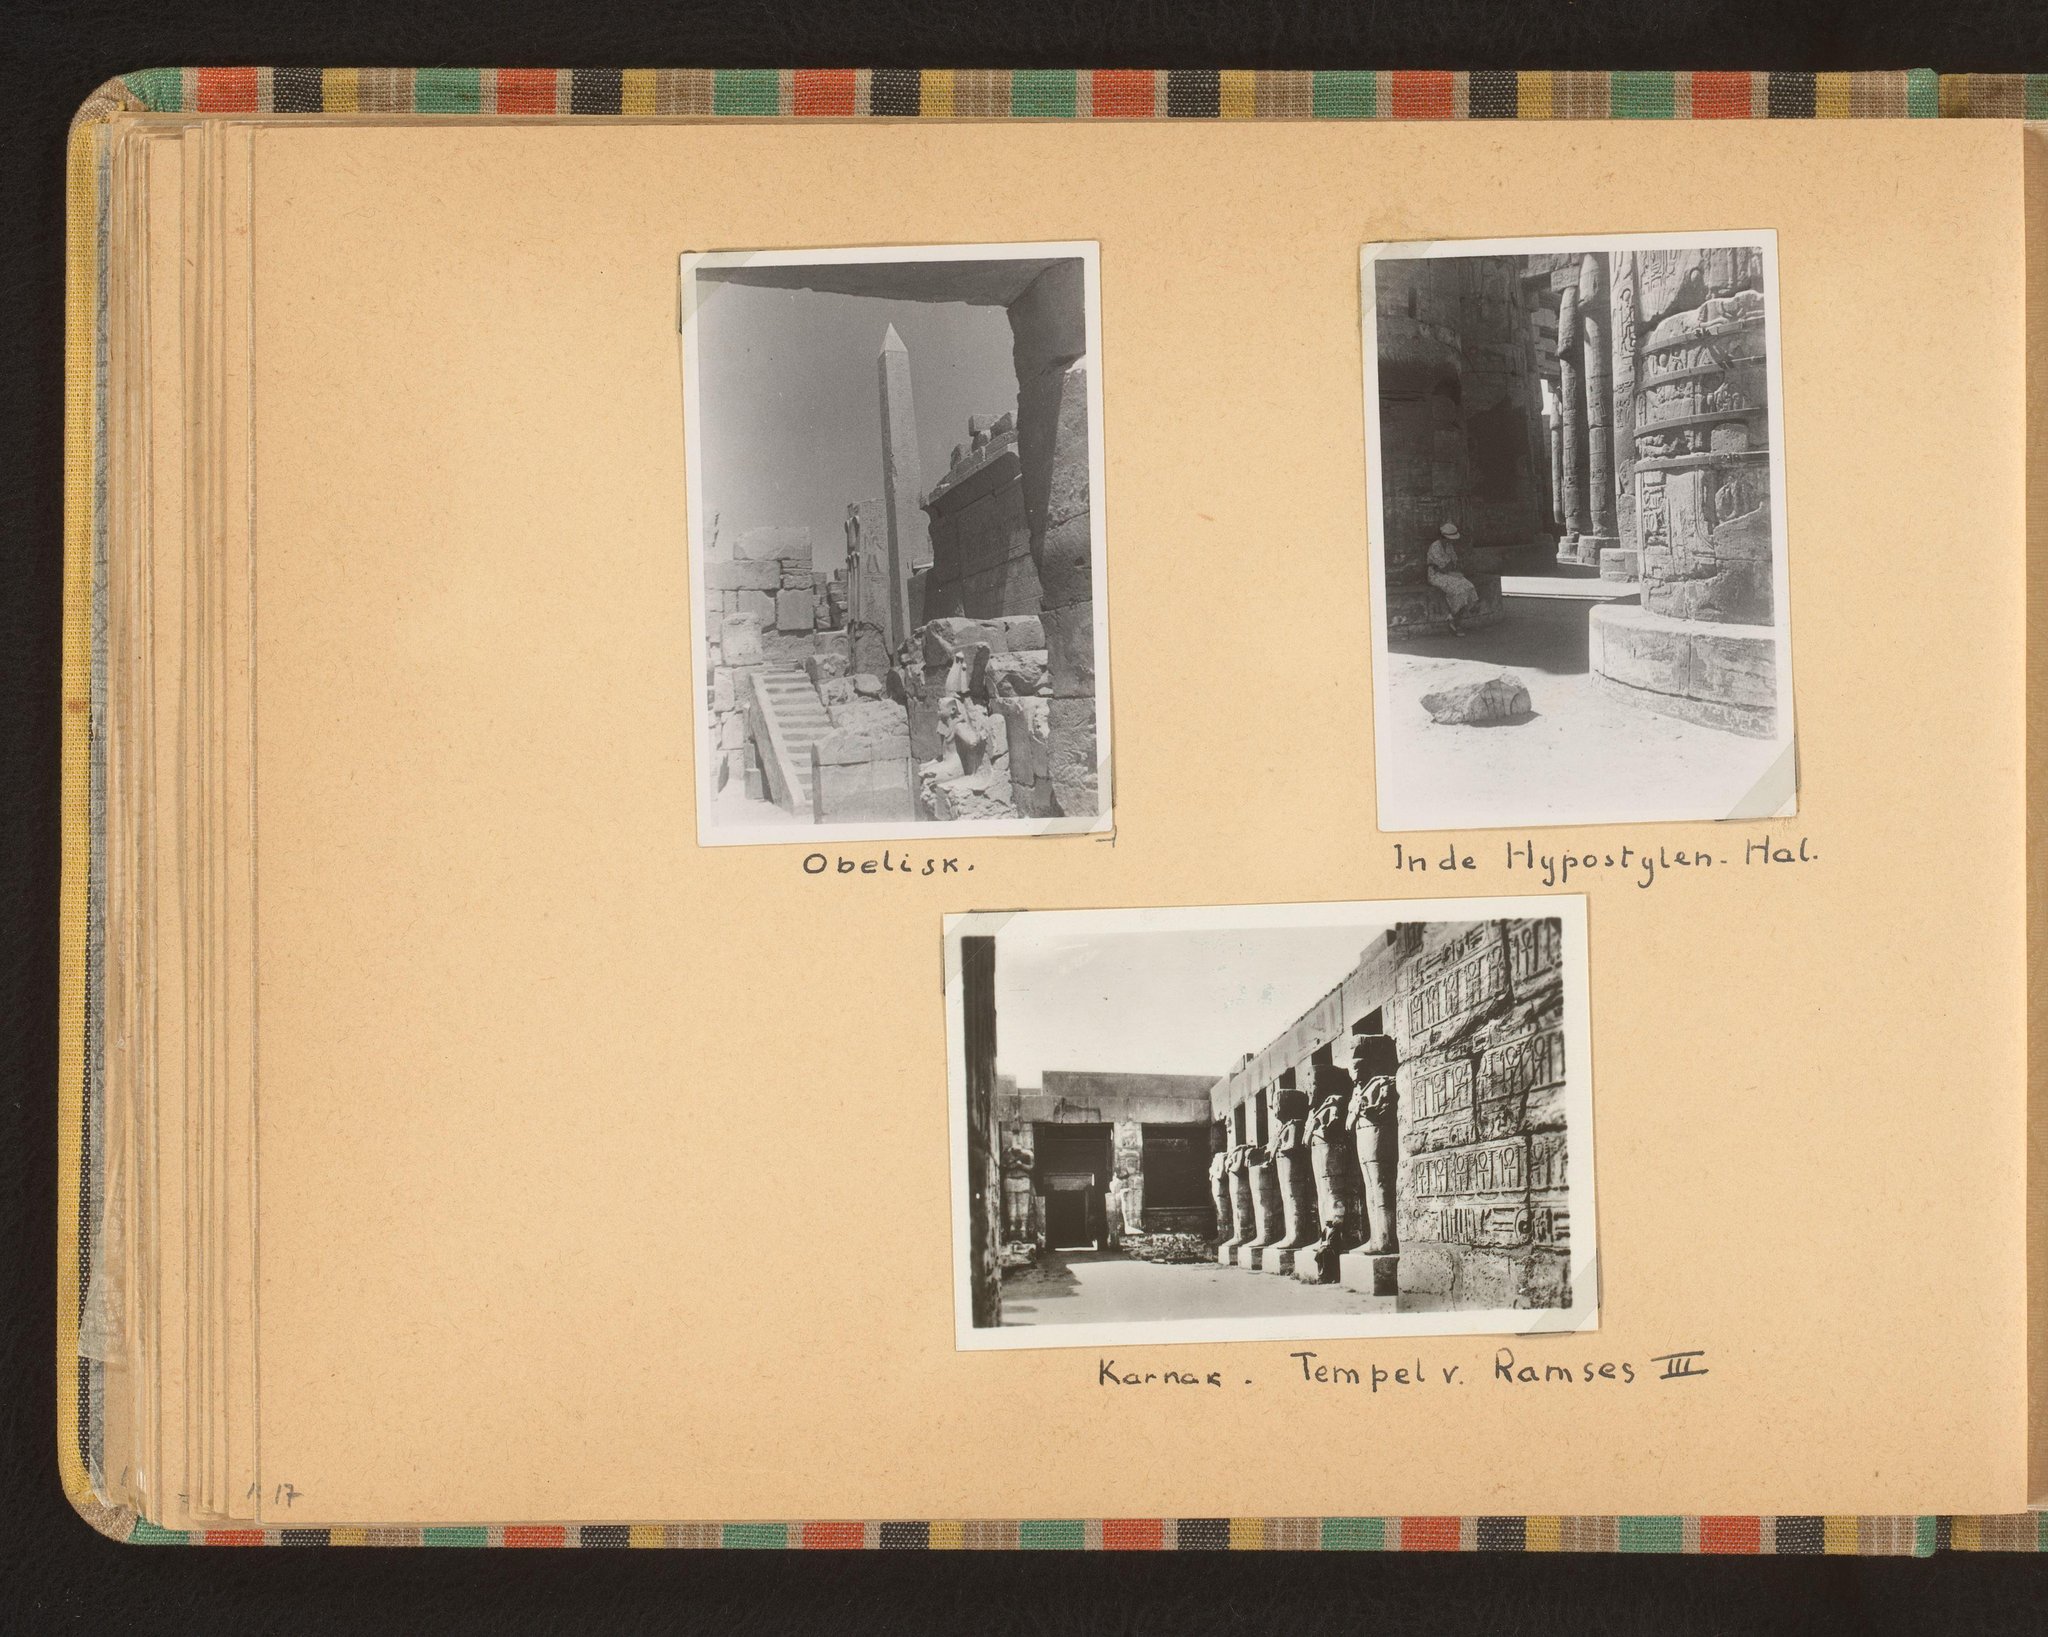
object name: photograph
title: Karnak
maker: Anonymous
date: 1936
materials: paper, photographic support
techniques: gelatin silver print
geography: egypt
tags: tourism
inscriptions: inscription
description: Albumblad met drie foto's van de Tempel van Amon in Karnak en de Tempel van Ramses III. Onderdeel van een album over een vakantiereis over de Nijl in 1936.